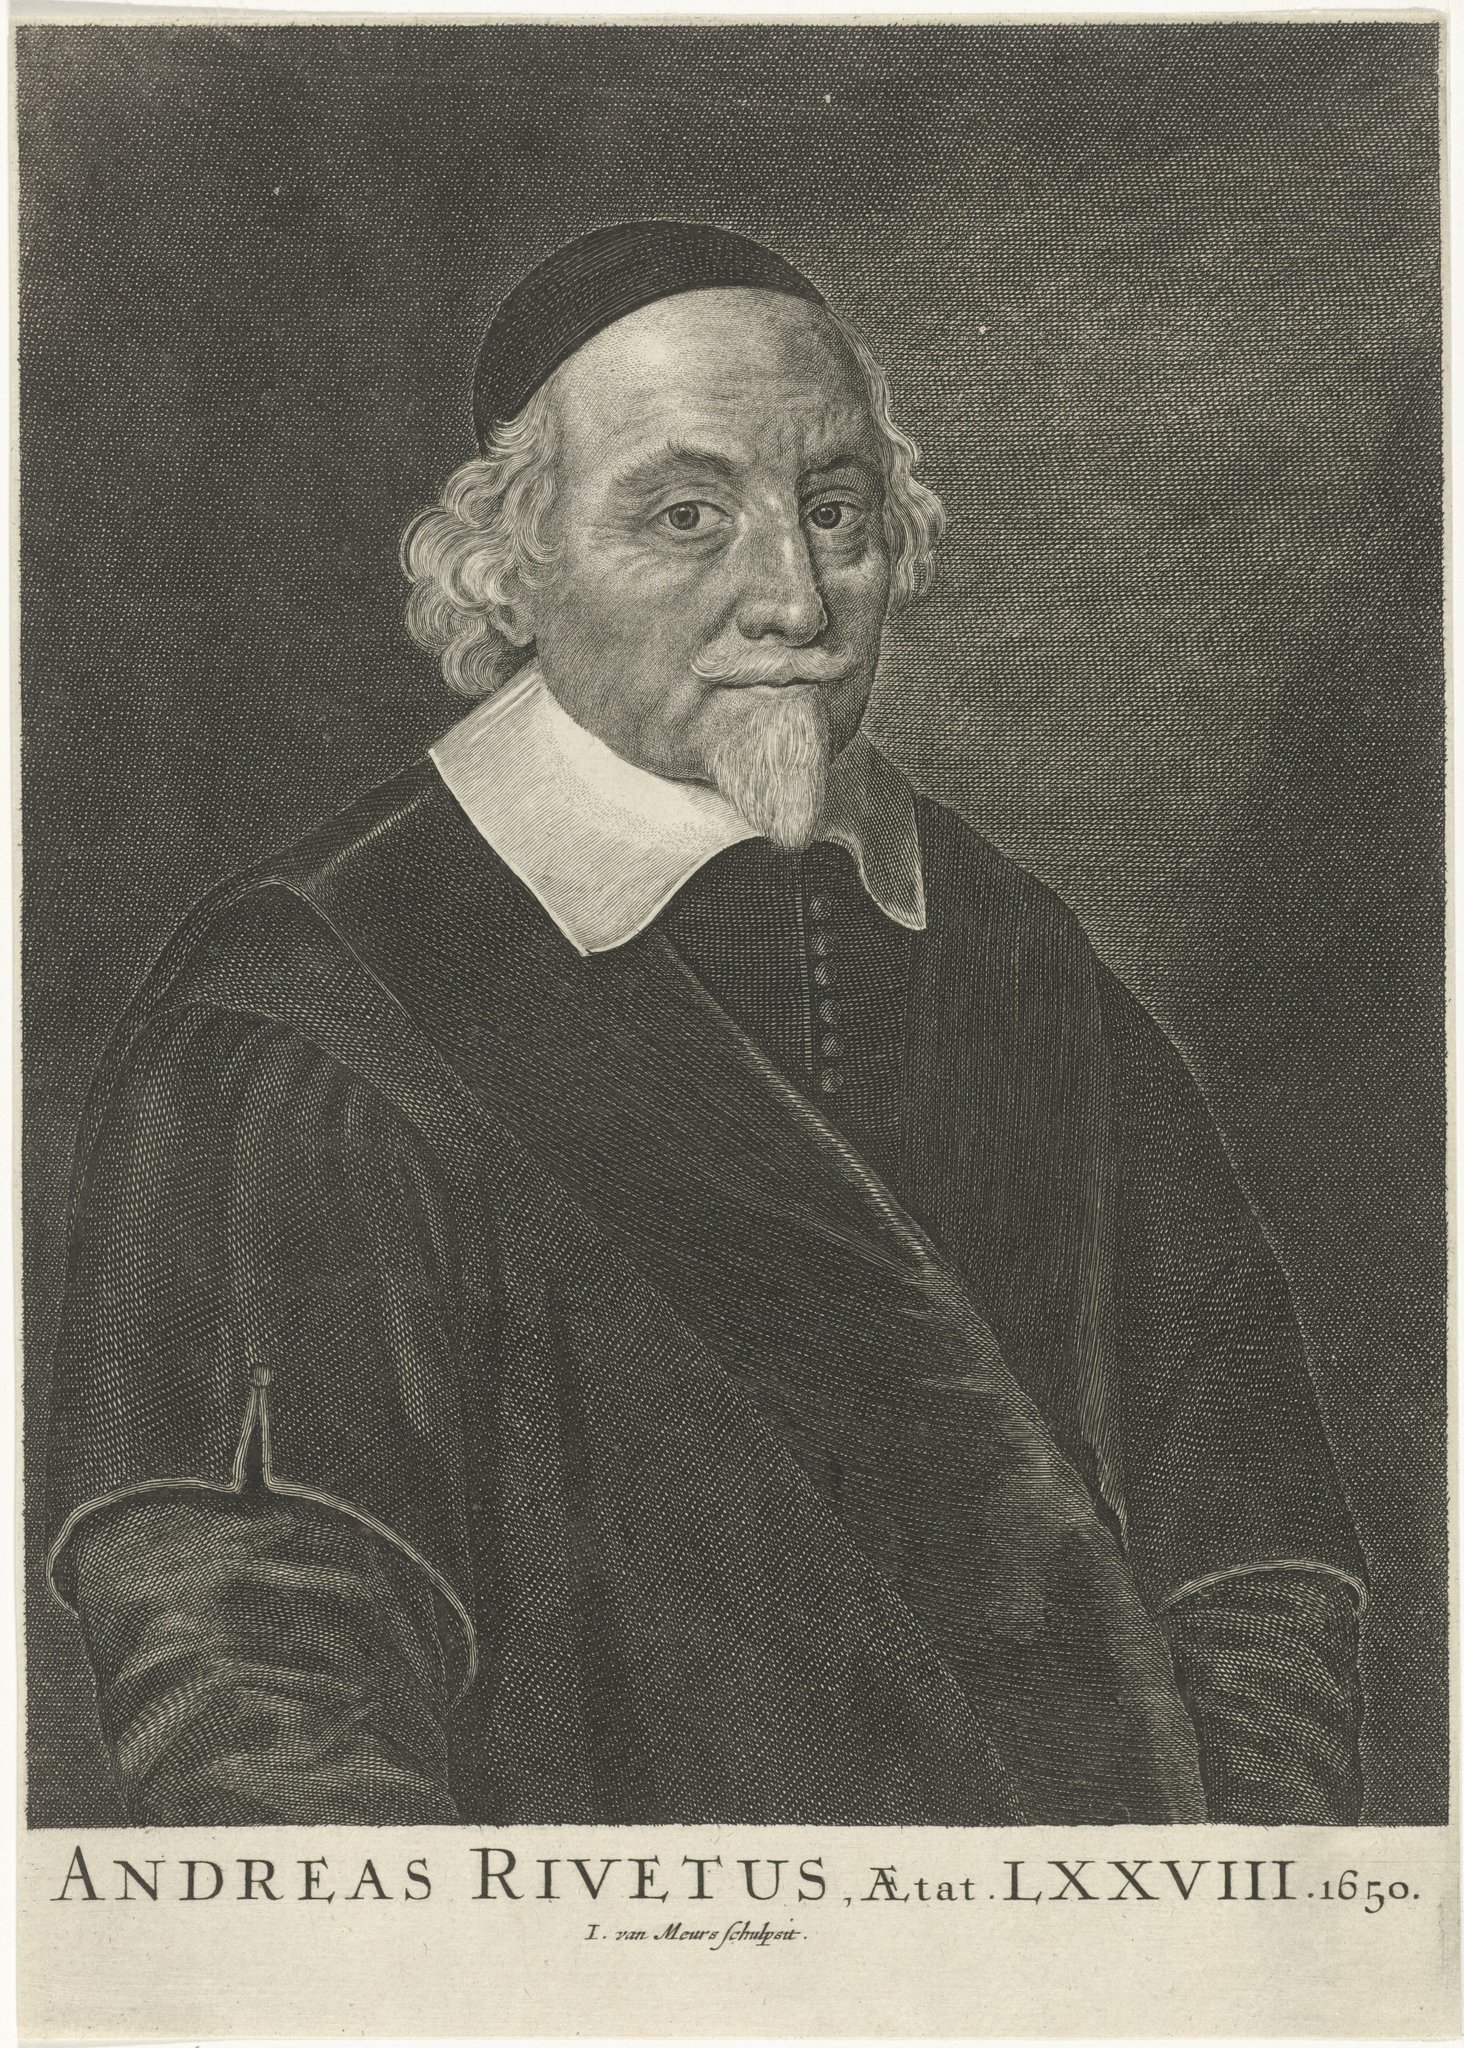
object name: print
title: Portret van André Rivet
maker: jacob van meurs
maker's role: draughtsman, print maker, publisher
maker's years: 1619-1680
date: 1650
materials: paper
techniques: engraving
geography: amsterdam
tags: andré rivet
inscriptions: collector's mark: Lugt 2228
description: Portret van André Rivet, professor in de theologie in Leiden, op 78-jarige leeftijd.